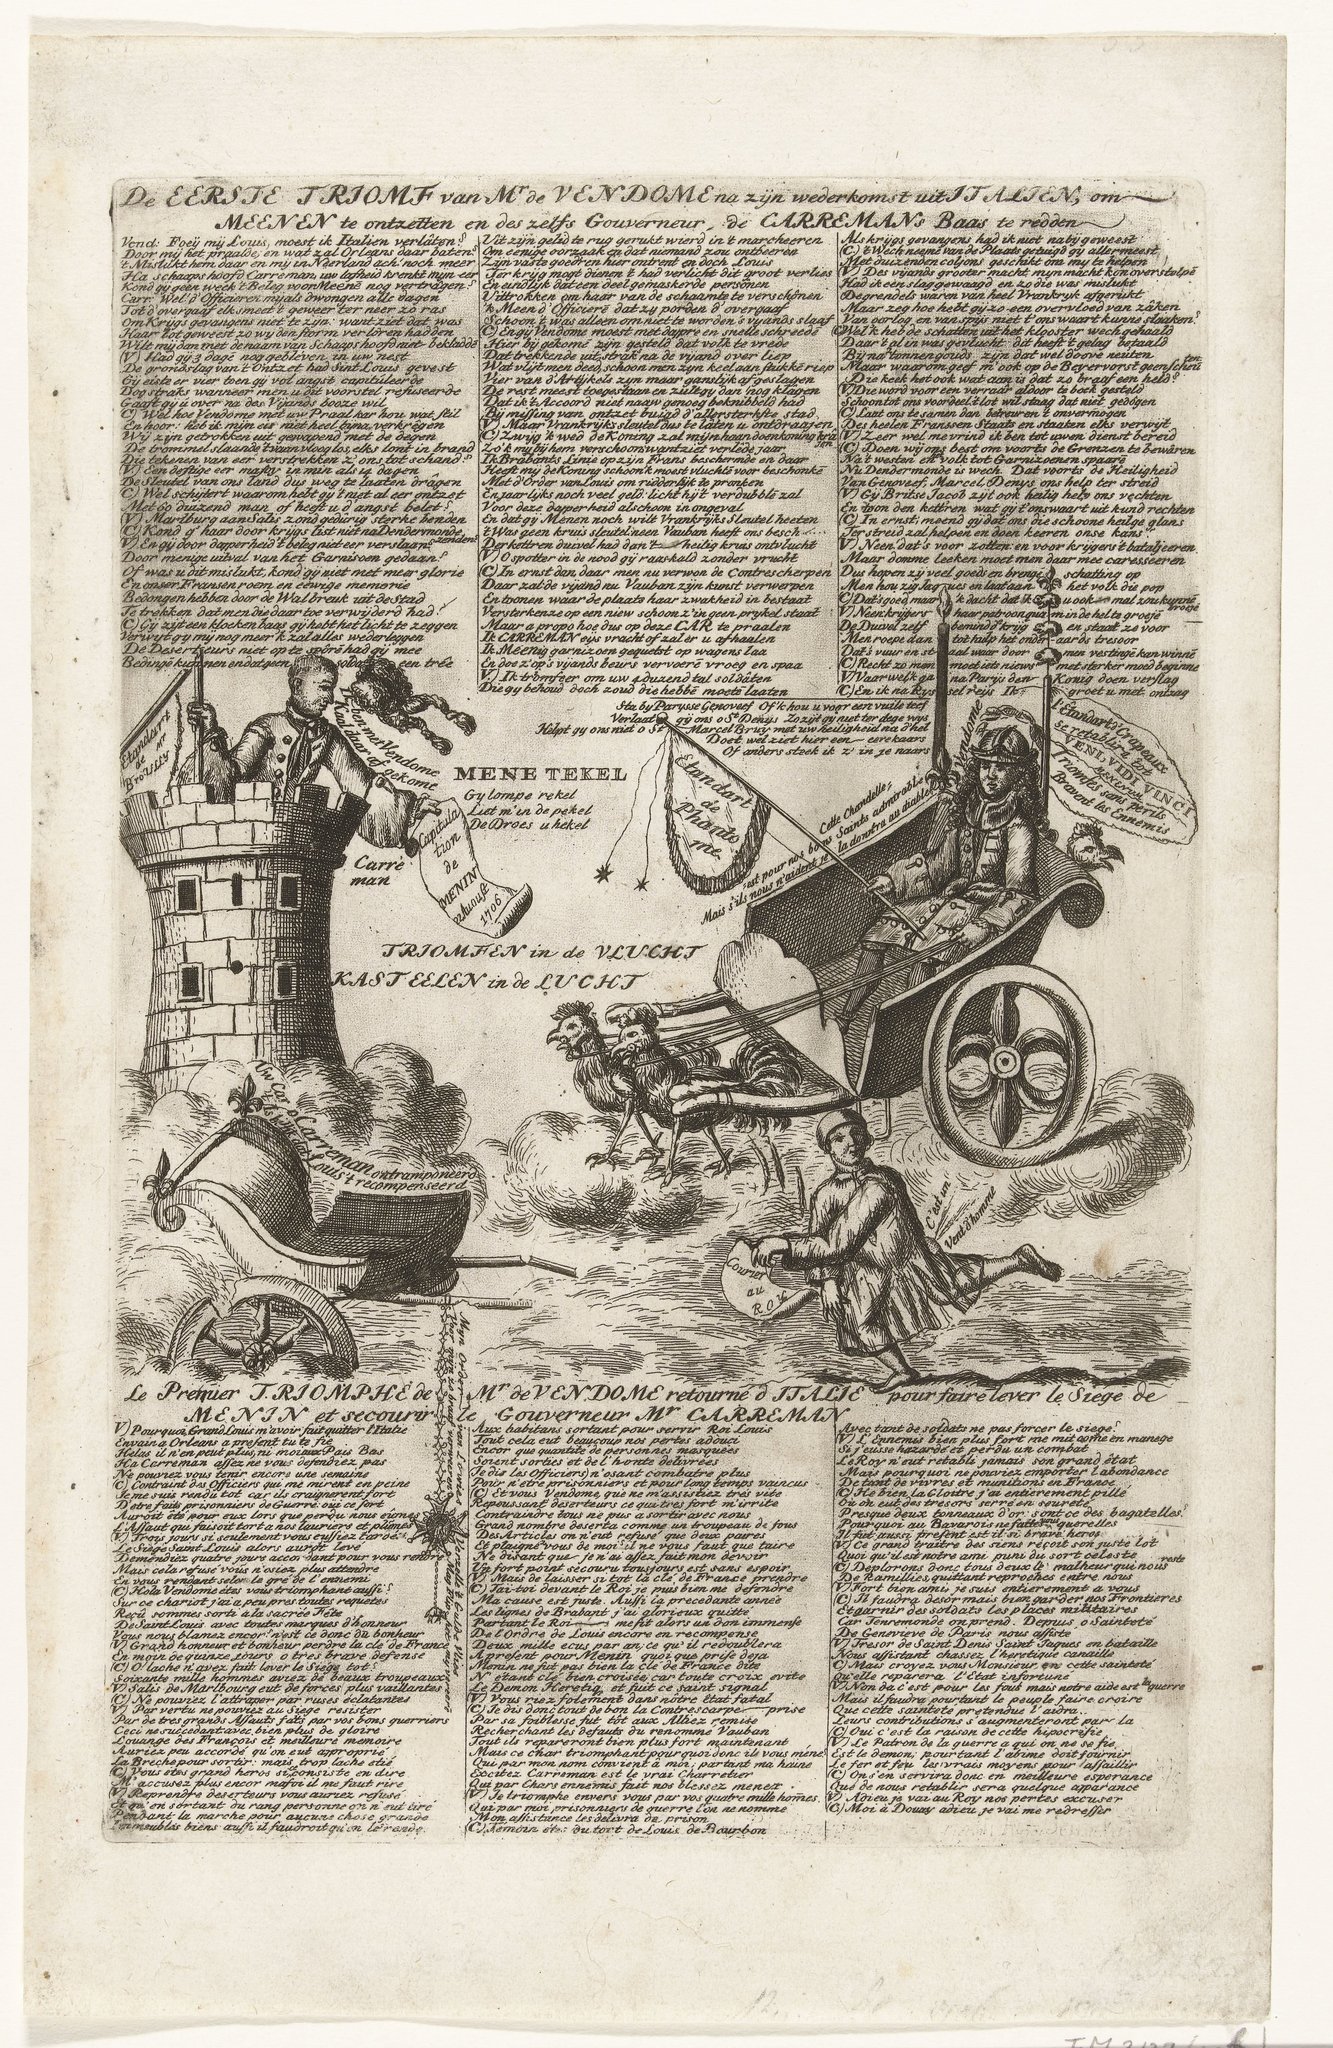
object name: cartoon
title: Spotprent op het verlies van Menen en de komst van de hertog van Vendôme uit Italië, 1706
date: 1706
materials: paper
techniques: etching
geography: northern netherlands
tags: political caricatures and satires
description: Spotprent op het verlies van Menen en de komst van de hertog van Vendôme vanuit Italië naar Brabant, 1706. Carremans, de bevelhebber te Menen, staande op een toren beklaagt de overgave van de stad op 22 augustus 1706. Vendôme in een strijdwagen getrokken door Franse hanen. In de plaat verzen in het Nederlands en Frans. Spotprent op de situatie in het jaar 1706 in de Spaanse Successieoorlog. Onderdeel van een reeks van 25 spotprenten op de Fransen en bondgenoten uit het jaar 1706.